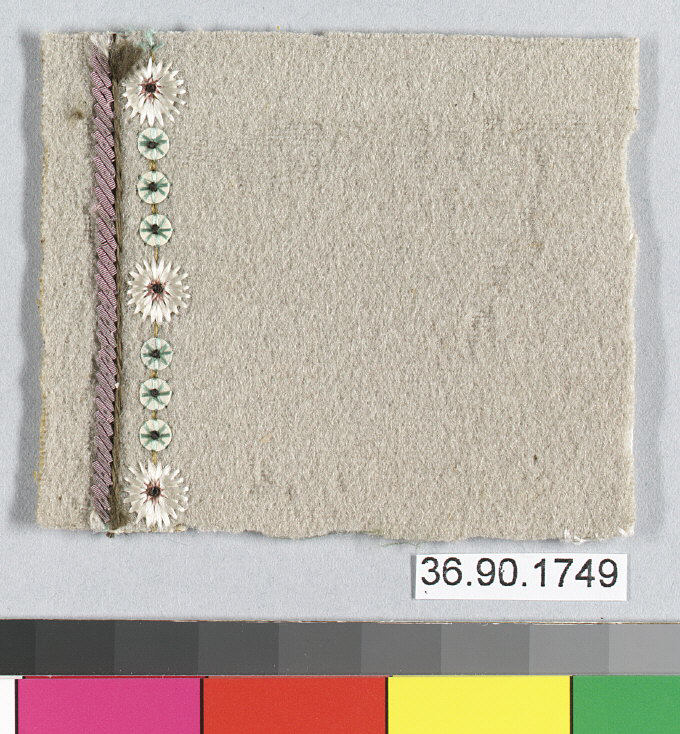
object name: sample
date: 1801-1833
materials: felt, metal thread, silk